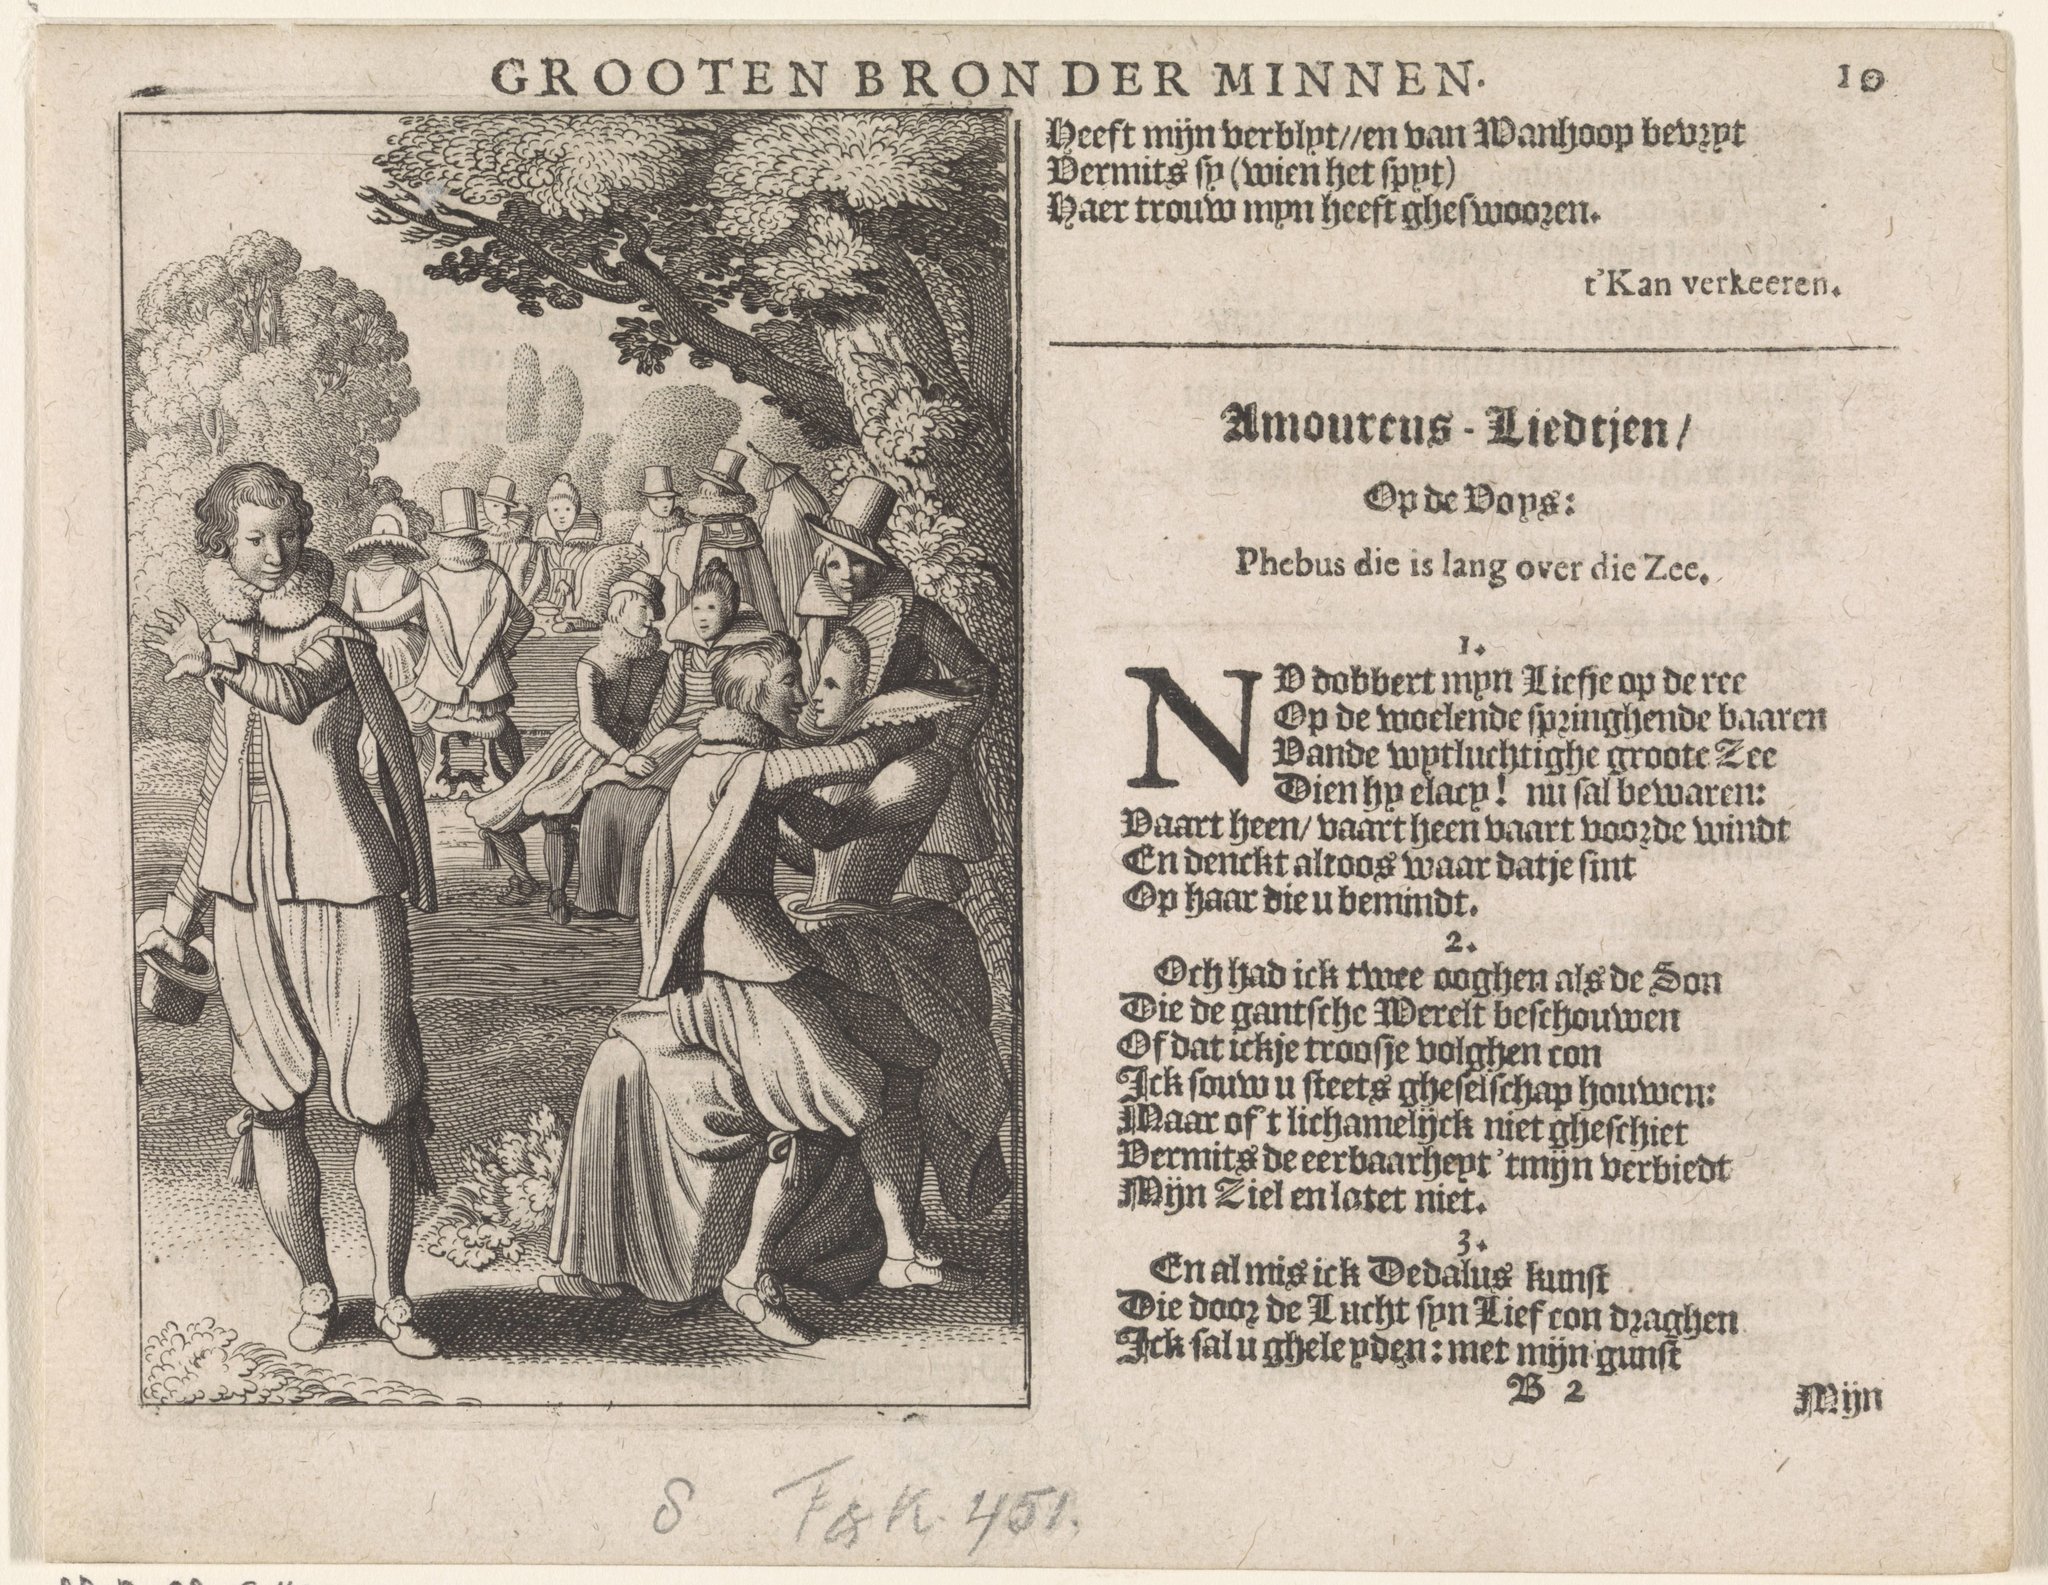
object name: book illustration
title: Verschrikte man bij vrijend paar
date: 1622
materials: paper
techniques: etching, letterpress printing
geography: amsterdam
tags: gesture-language (+ relations with aggressive, hostile character (expressive connotations)), (lovers) caressing each other, arm raised, with fingers spread out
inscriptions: collector's mark: Lugt 964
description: Een jonge man met opgeheven hand bij een minnekozend paar in een tuin. Op de achtergrond andere paren rond een tafel. Boekillustratie uit G.A. Bredero, Boertigh, amoreus, en aendachtigh groot lied-boeck, 1622. Rechtsboven paginanummer 10.